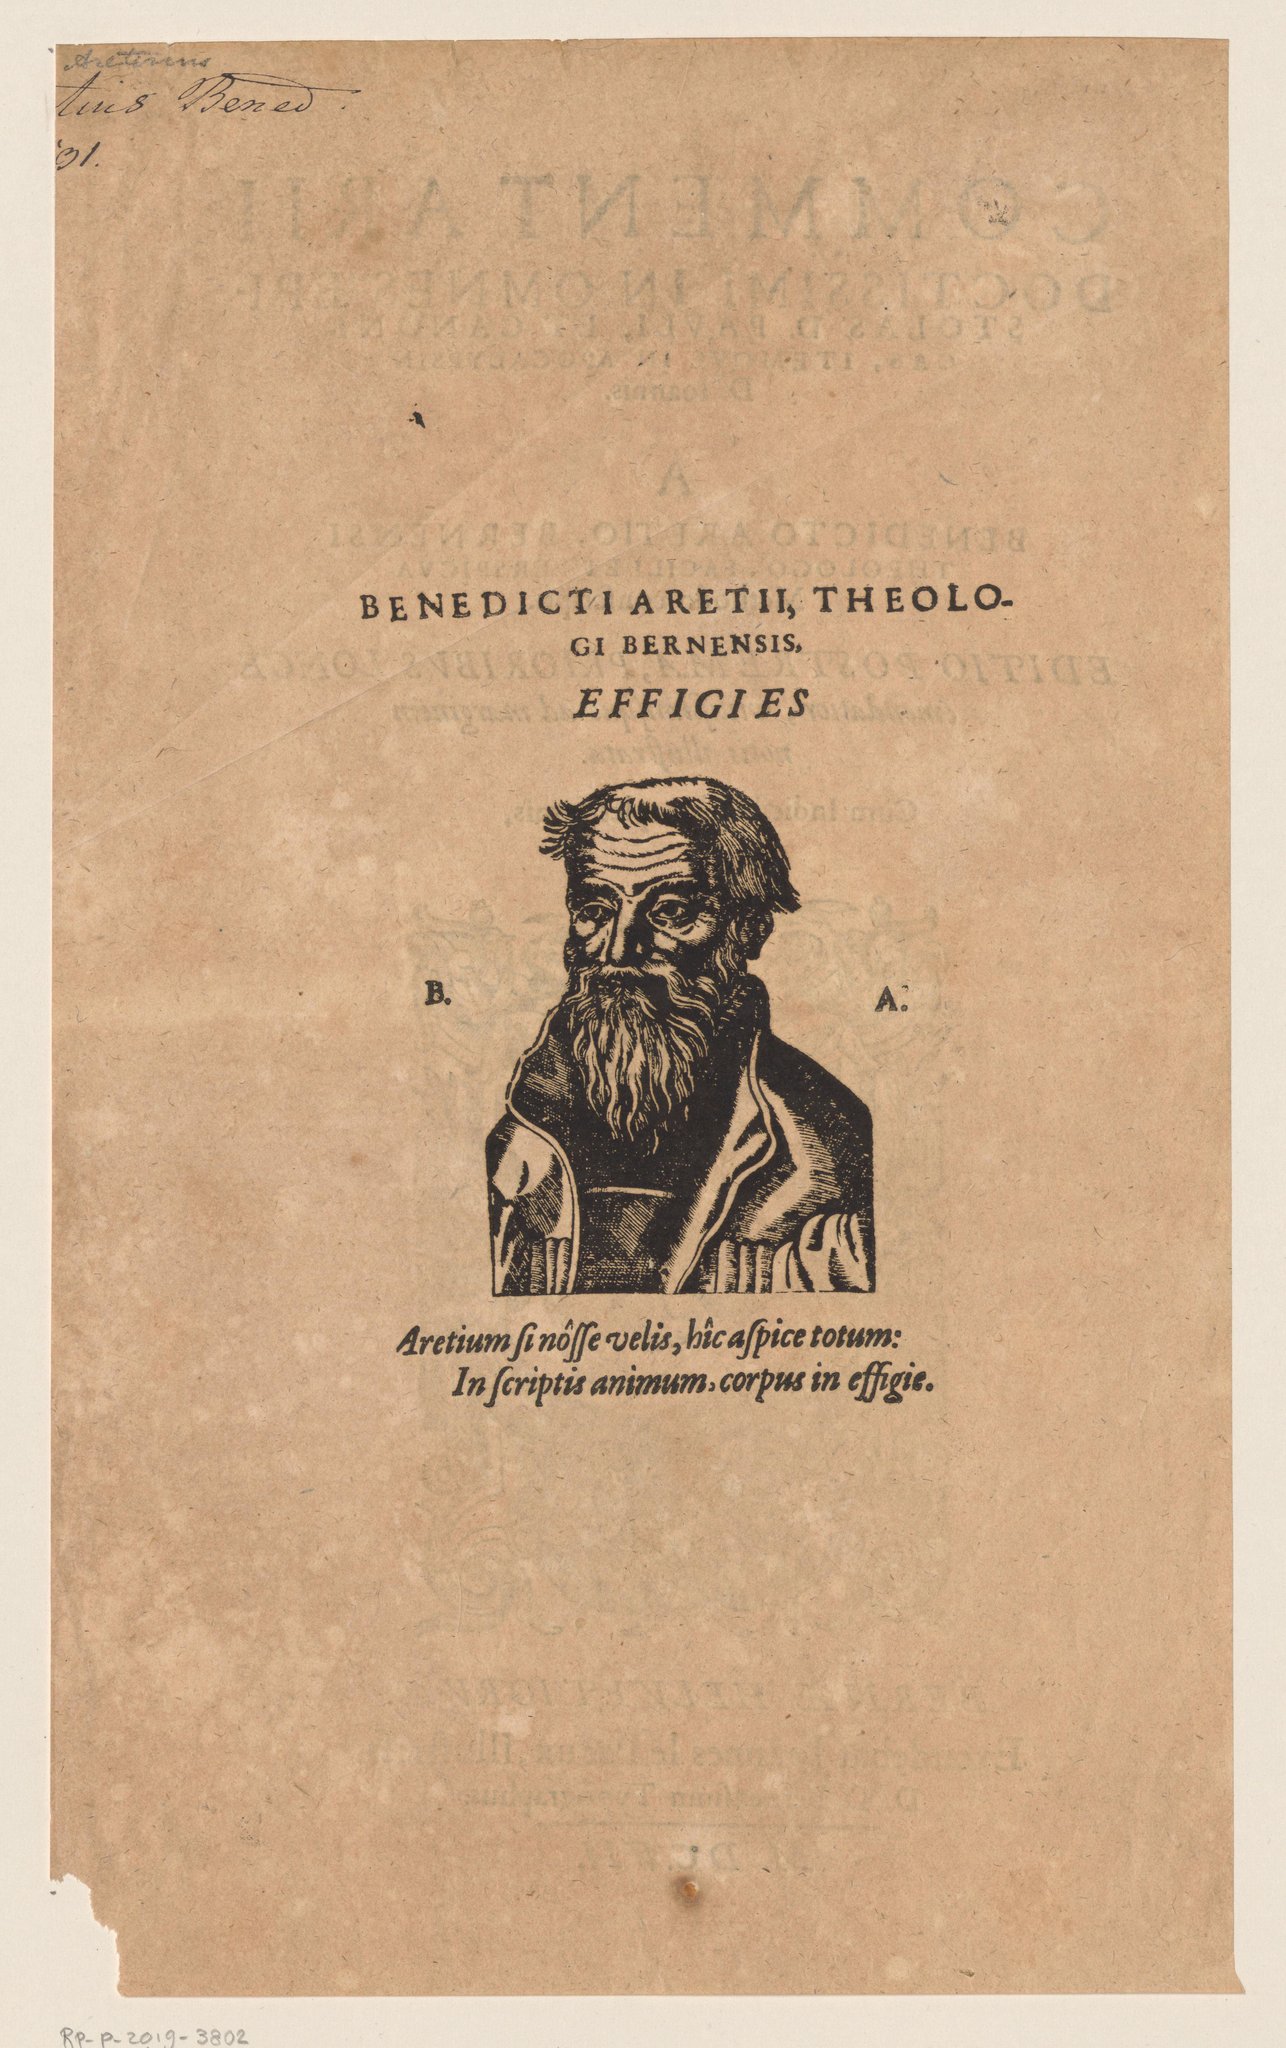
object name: book illustration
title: Portret van Benedictus Aretius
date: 1607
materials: paper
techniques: letterpress printing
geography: bern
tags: theologian, historical persons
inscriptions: inscription: ‘[...] tius Bened. [...] 31.’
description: Prent uit: Aretius, Benedictus. Commentarii doctissimi in omnes epistolas D. Pauli, et canonicas (...). Bern: Jean le Preux, 1607.